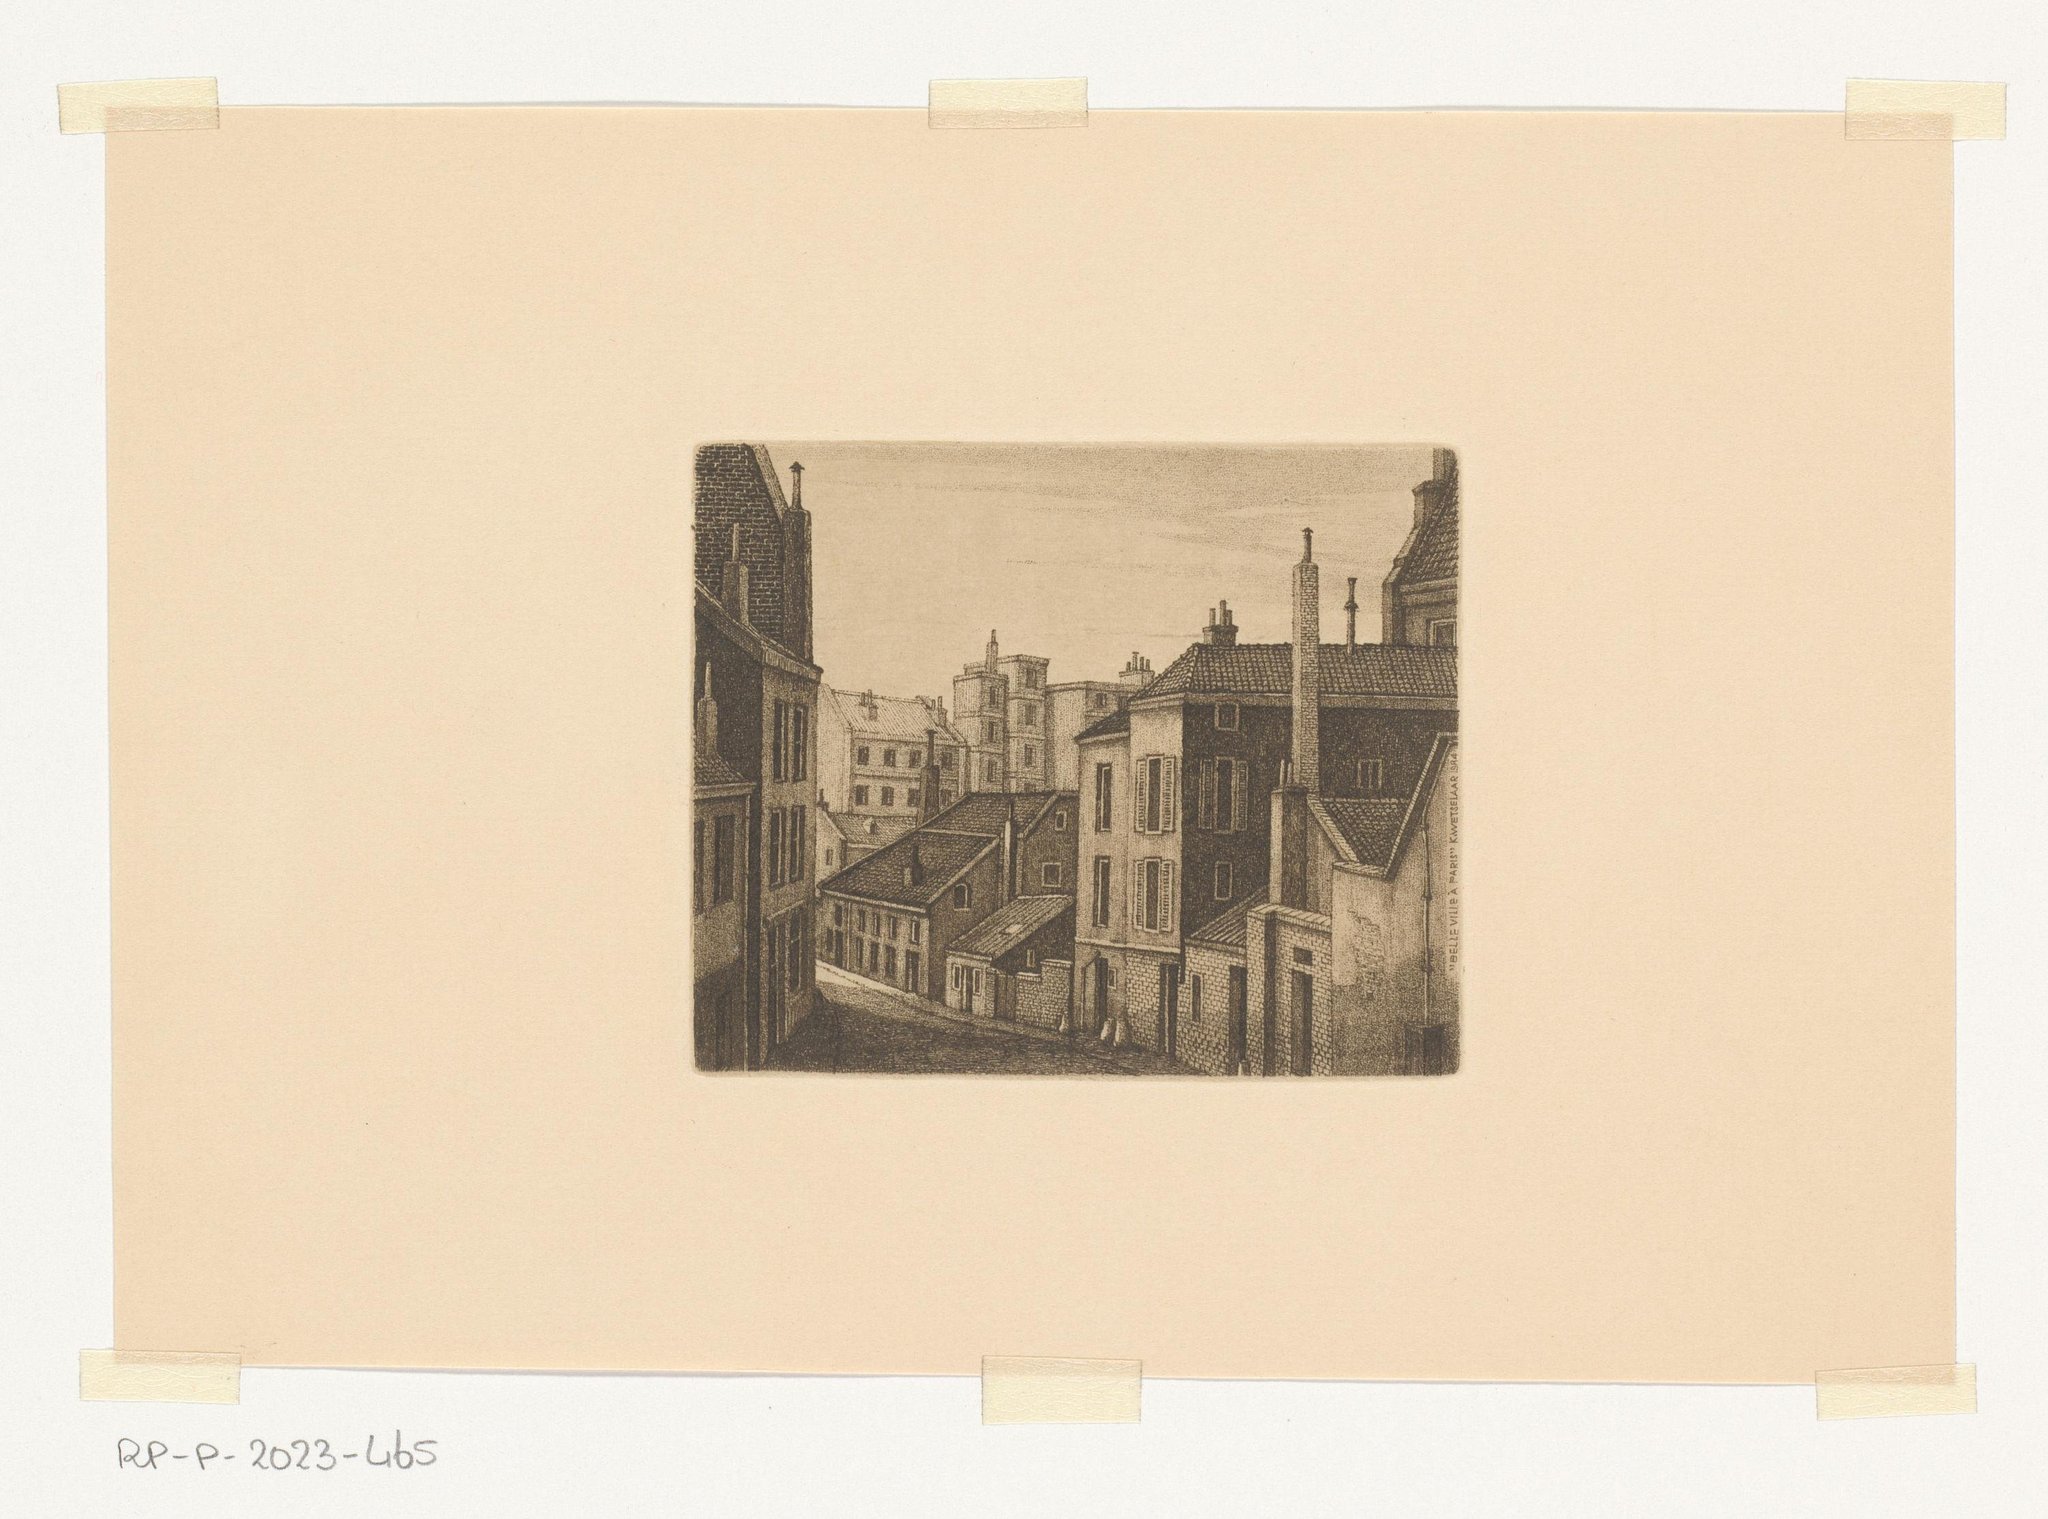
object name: print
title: Belle Ville A Paris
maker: karel wetselaar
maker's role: print maker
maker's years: 1935-2017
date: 1984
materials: paper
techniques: etching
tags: city-view in general; 'veduta', street, paris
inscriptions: signature and date: ‘K. Wetselaar 1984’